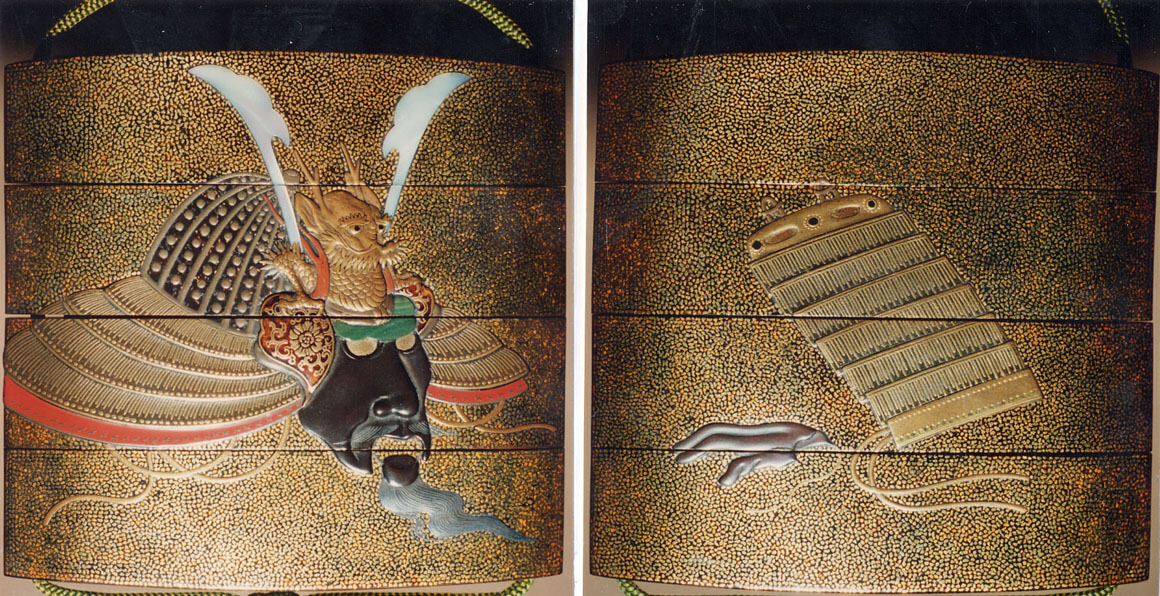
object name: inrō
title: Case (Inrō) with Design of Samurai Helmet and Face Mask (obverse); Samurai Arm Guard and Silver Glove (reverse)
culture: japanese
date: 1801-1900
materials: gold, lacquer, silver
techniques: fundame, hiramakie, inlay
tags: masks,armor,helmets